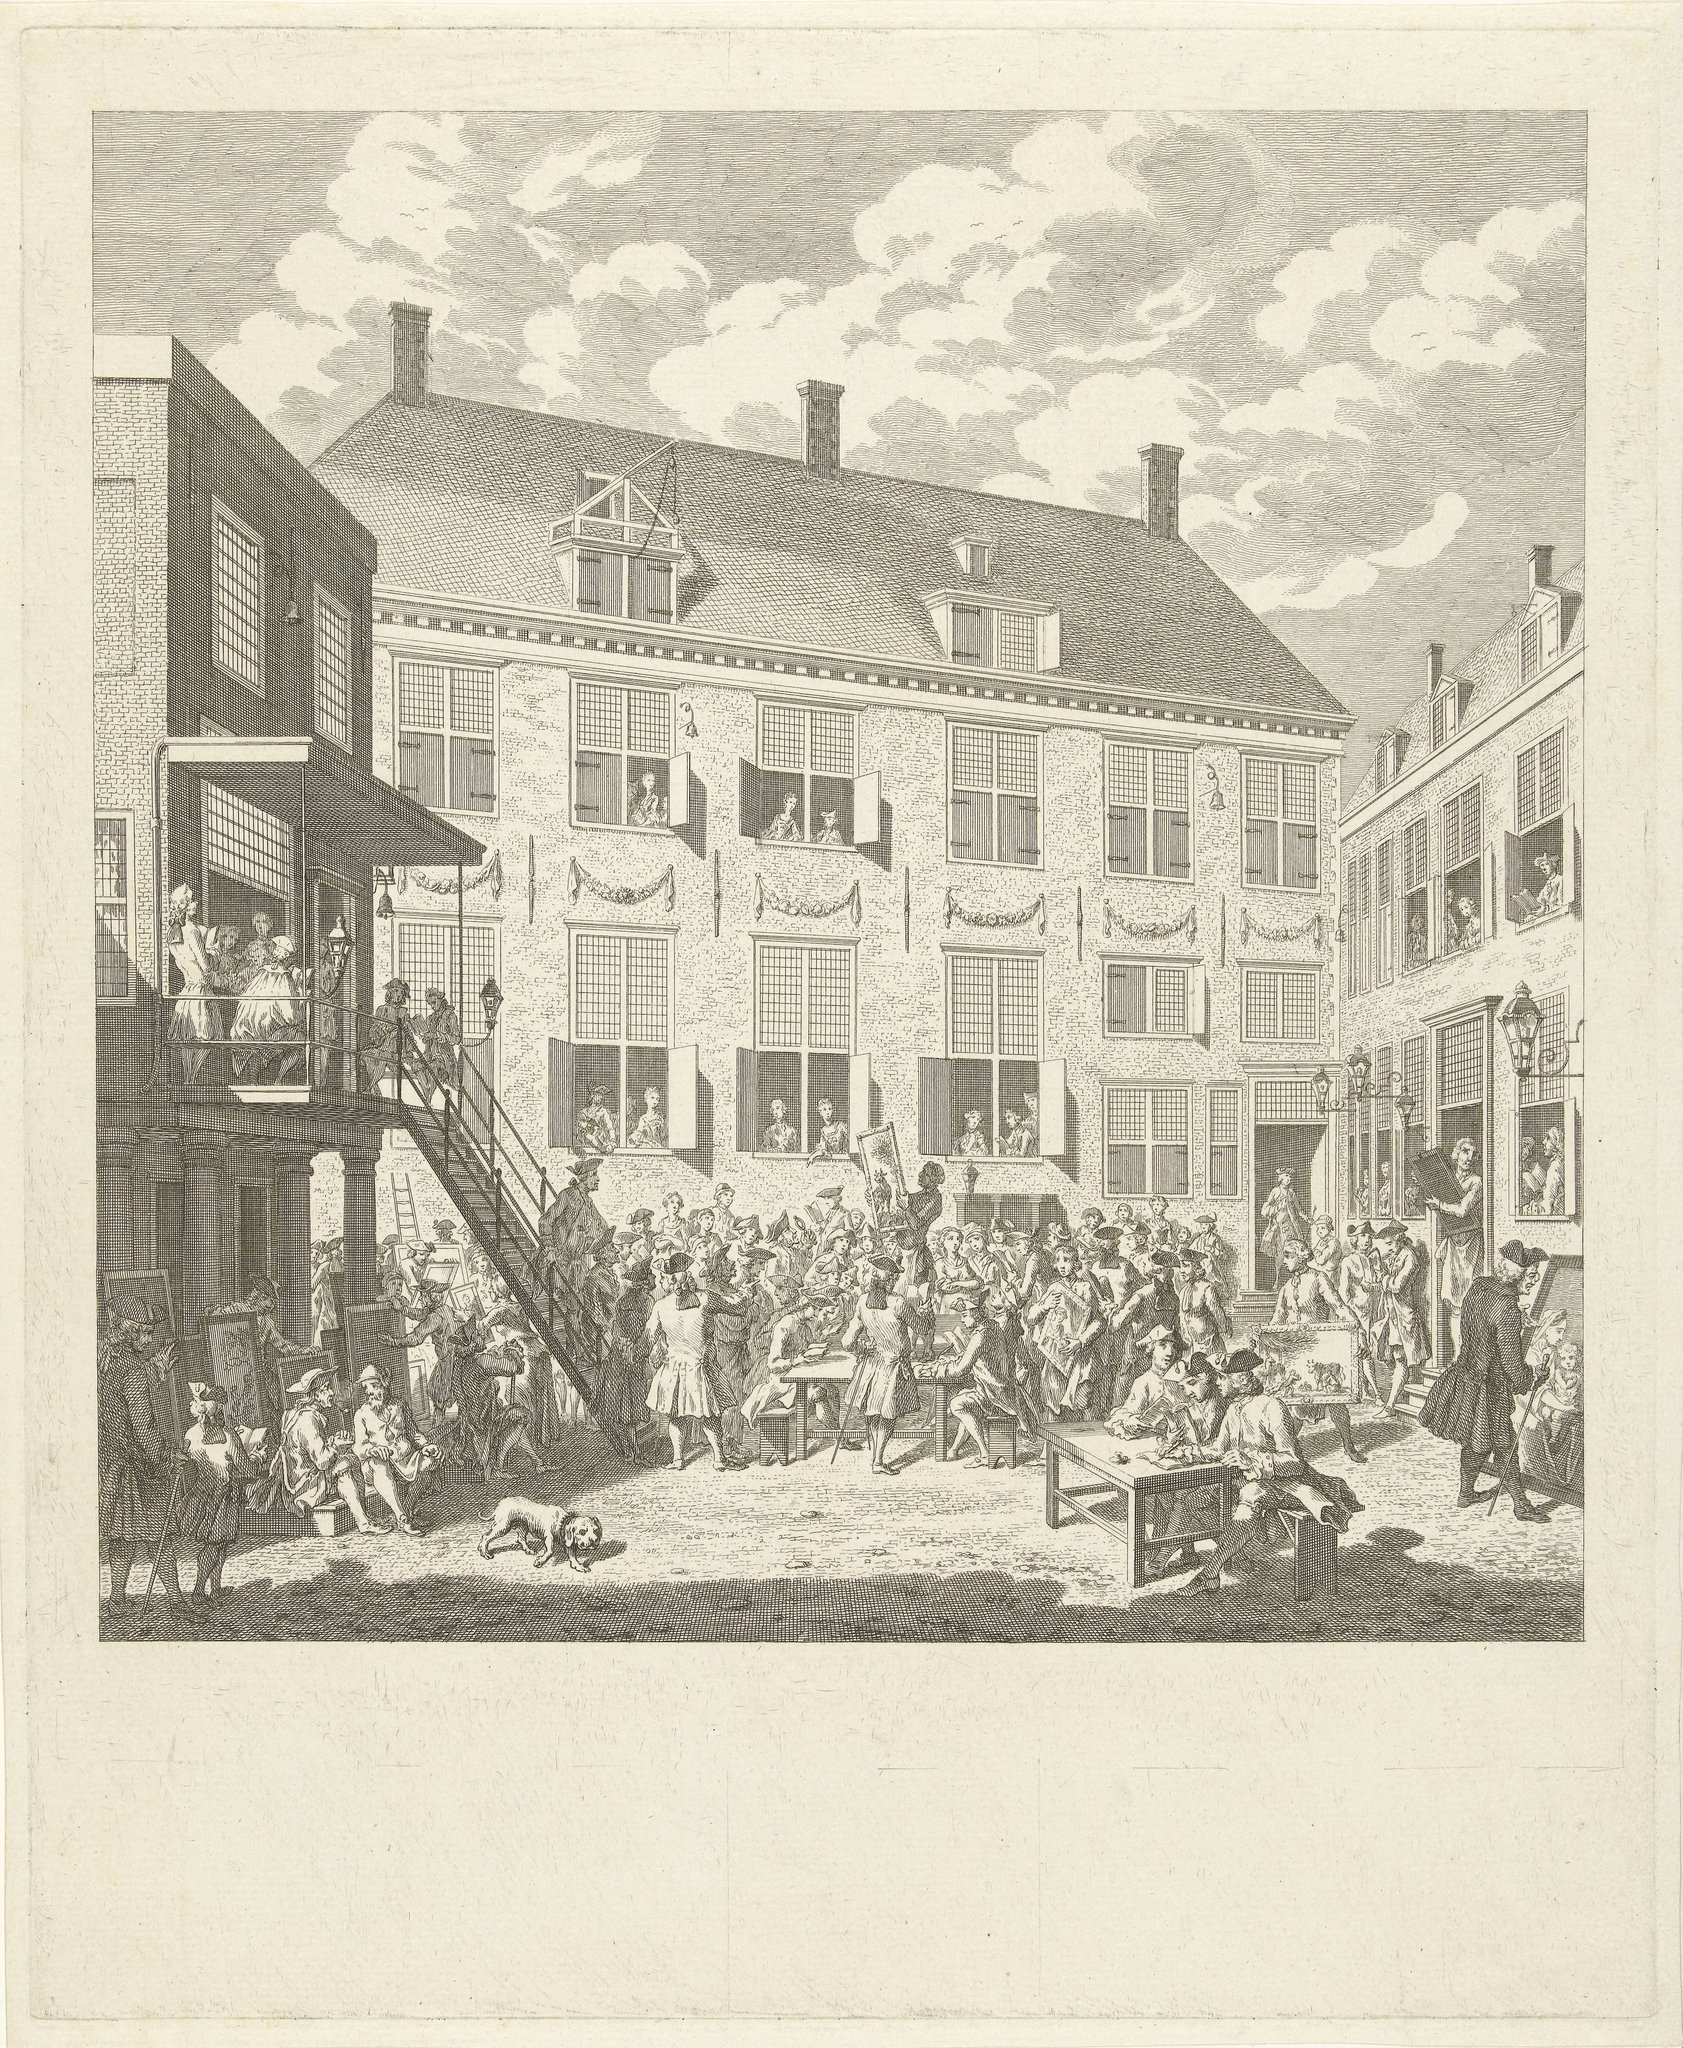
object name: print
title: Gezicht op het Oudezijds Herenlogement te Amsterdam en een schilderijenverkoop, 1773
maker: simon fokke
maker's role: draughtsman, print maker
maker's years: 1712-1784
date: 1774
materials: paper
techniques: etching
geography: amsterdam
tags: art sale, auction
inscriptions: collector's mark: Lugt 2233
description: Gezicht op de binnenplaats van het Oudezijds Herenlogement te Amsterdam waar een schilderijenverkoop plaatsvindt. Waarschijnlijk betreft het de openbare verkoop of veiling van de schilderijenverzameling van de in 1772 overleden Leidse burgemeester Johan van der Markt Aegidsz. op 25 augustus 1773.